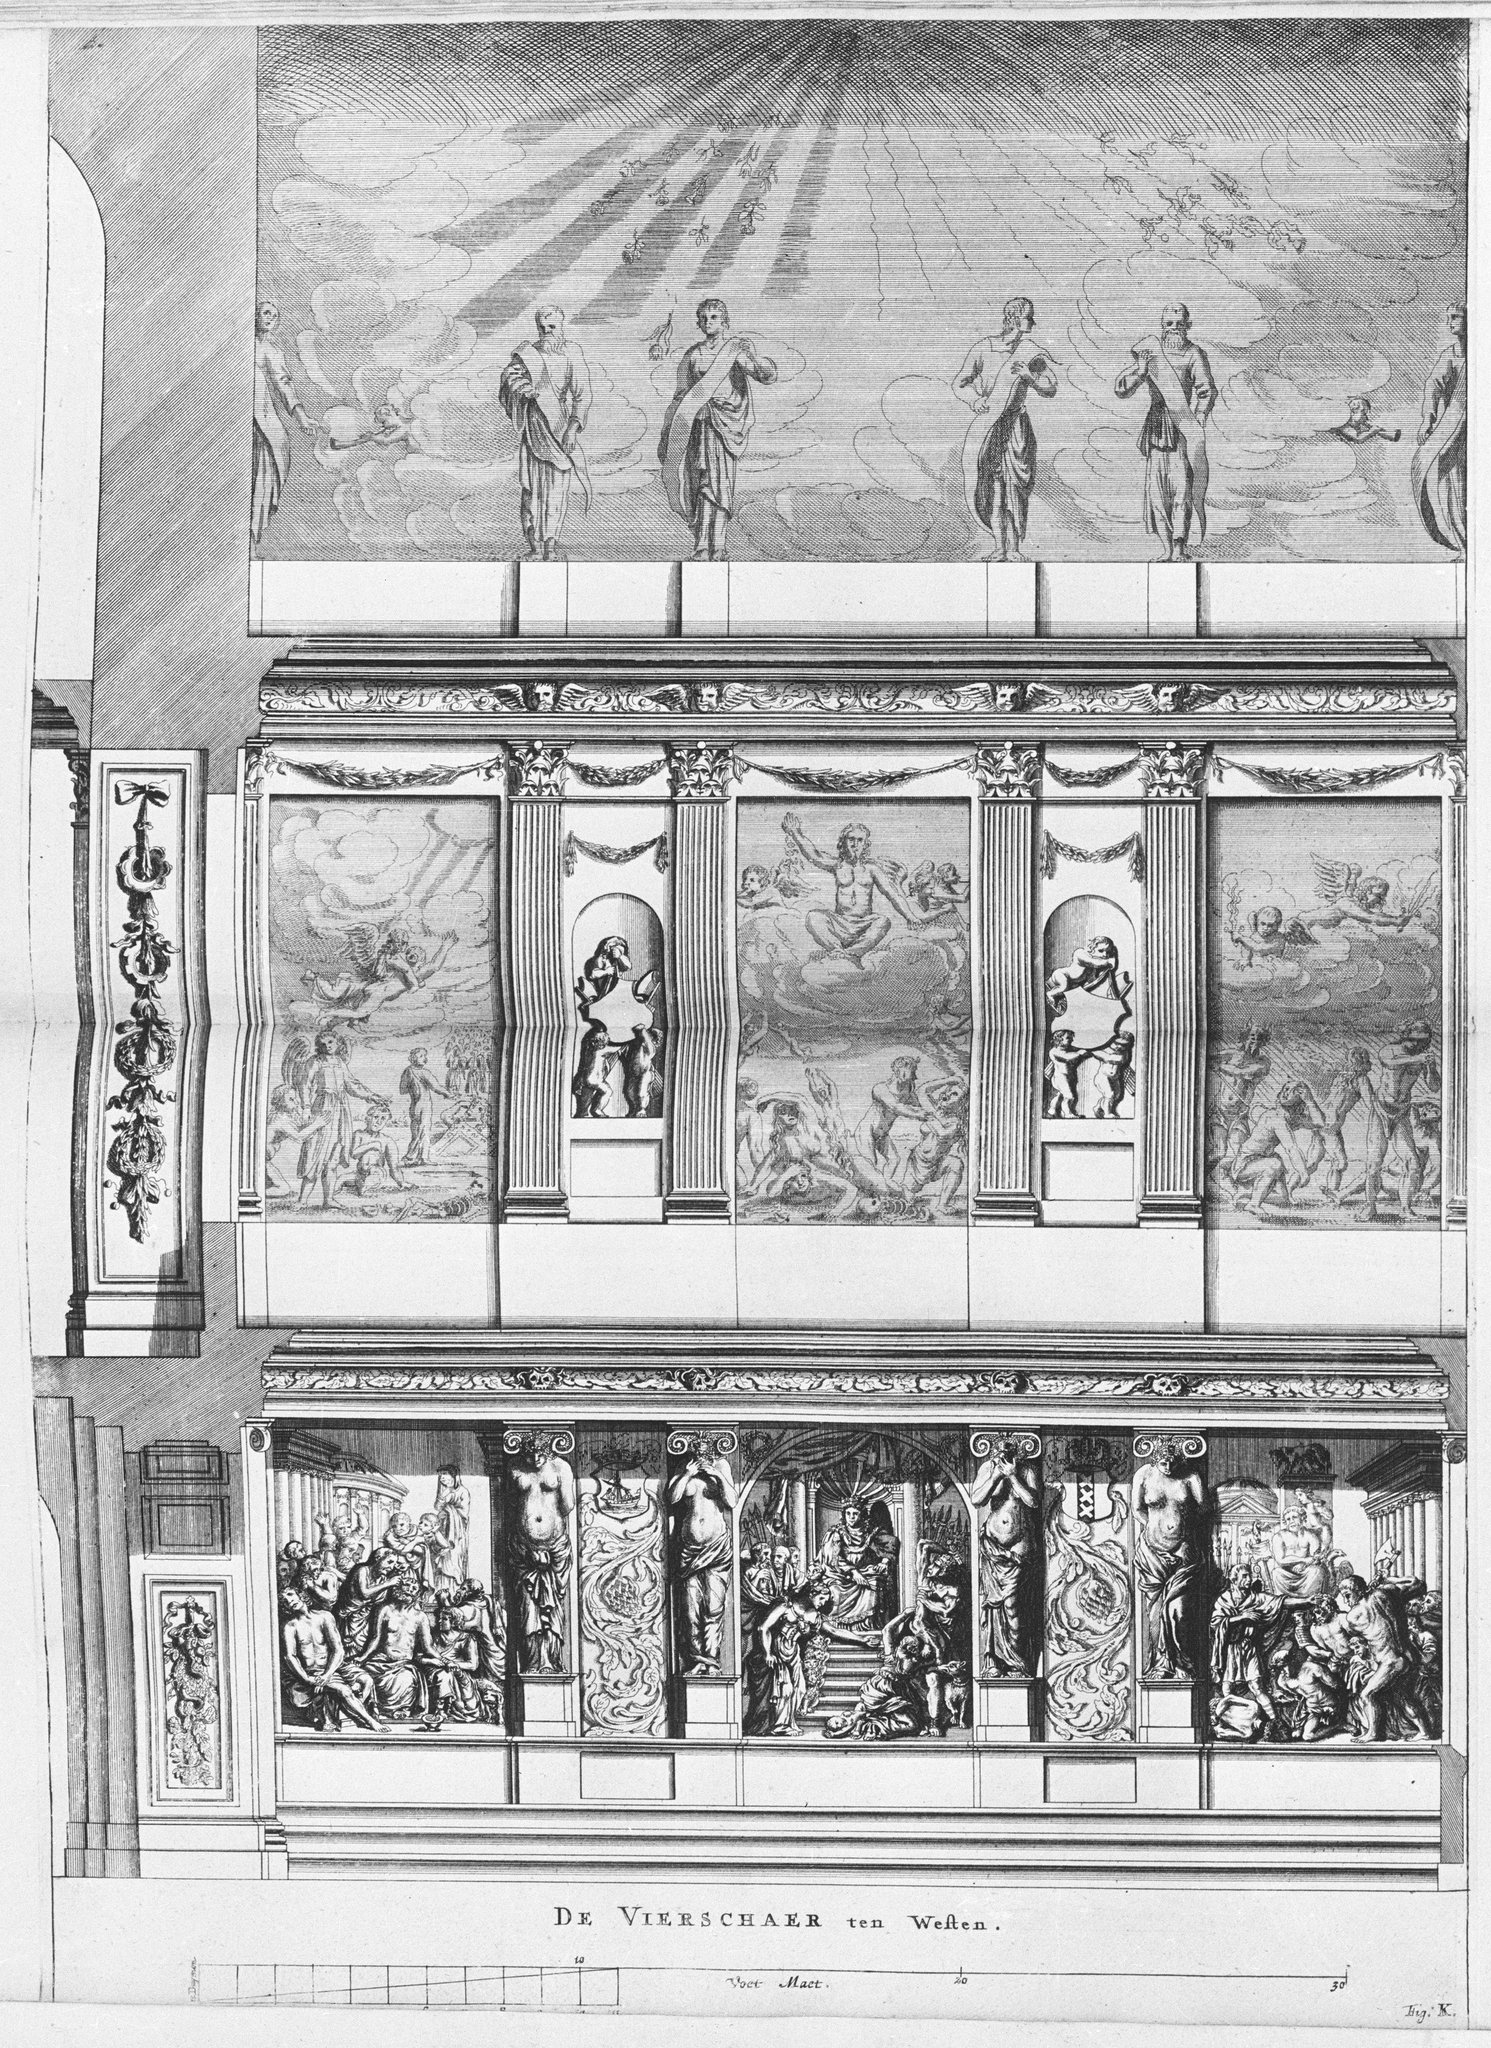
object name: book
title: I) Afbeelding van't Stadt Huys van Amsterdam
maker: jacob van campen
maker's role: author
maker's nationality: dutch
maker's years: 1595-1657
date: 1665-1668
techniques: etching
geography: netherlands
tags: architecture